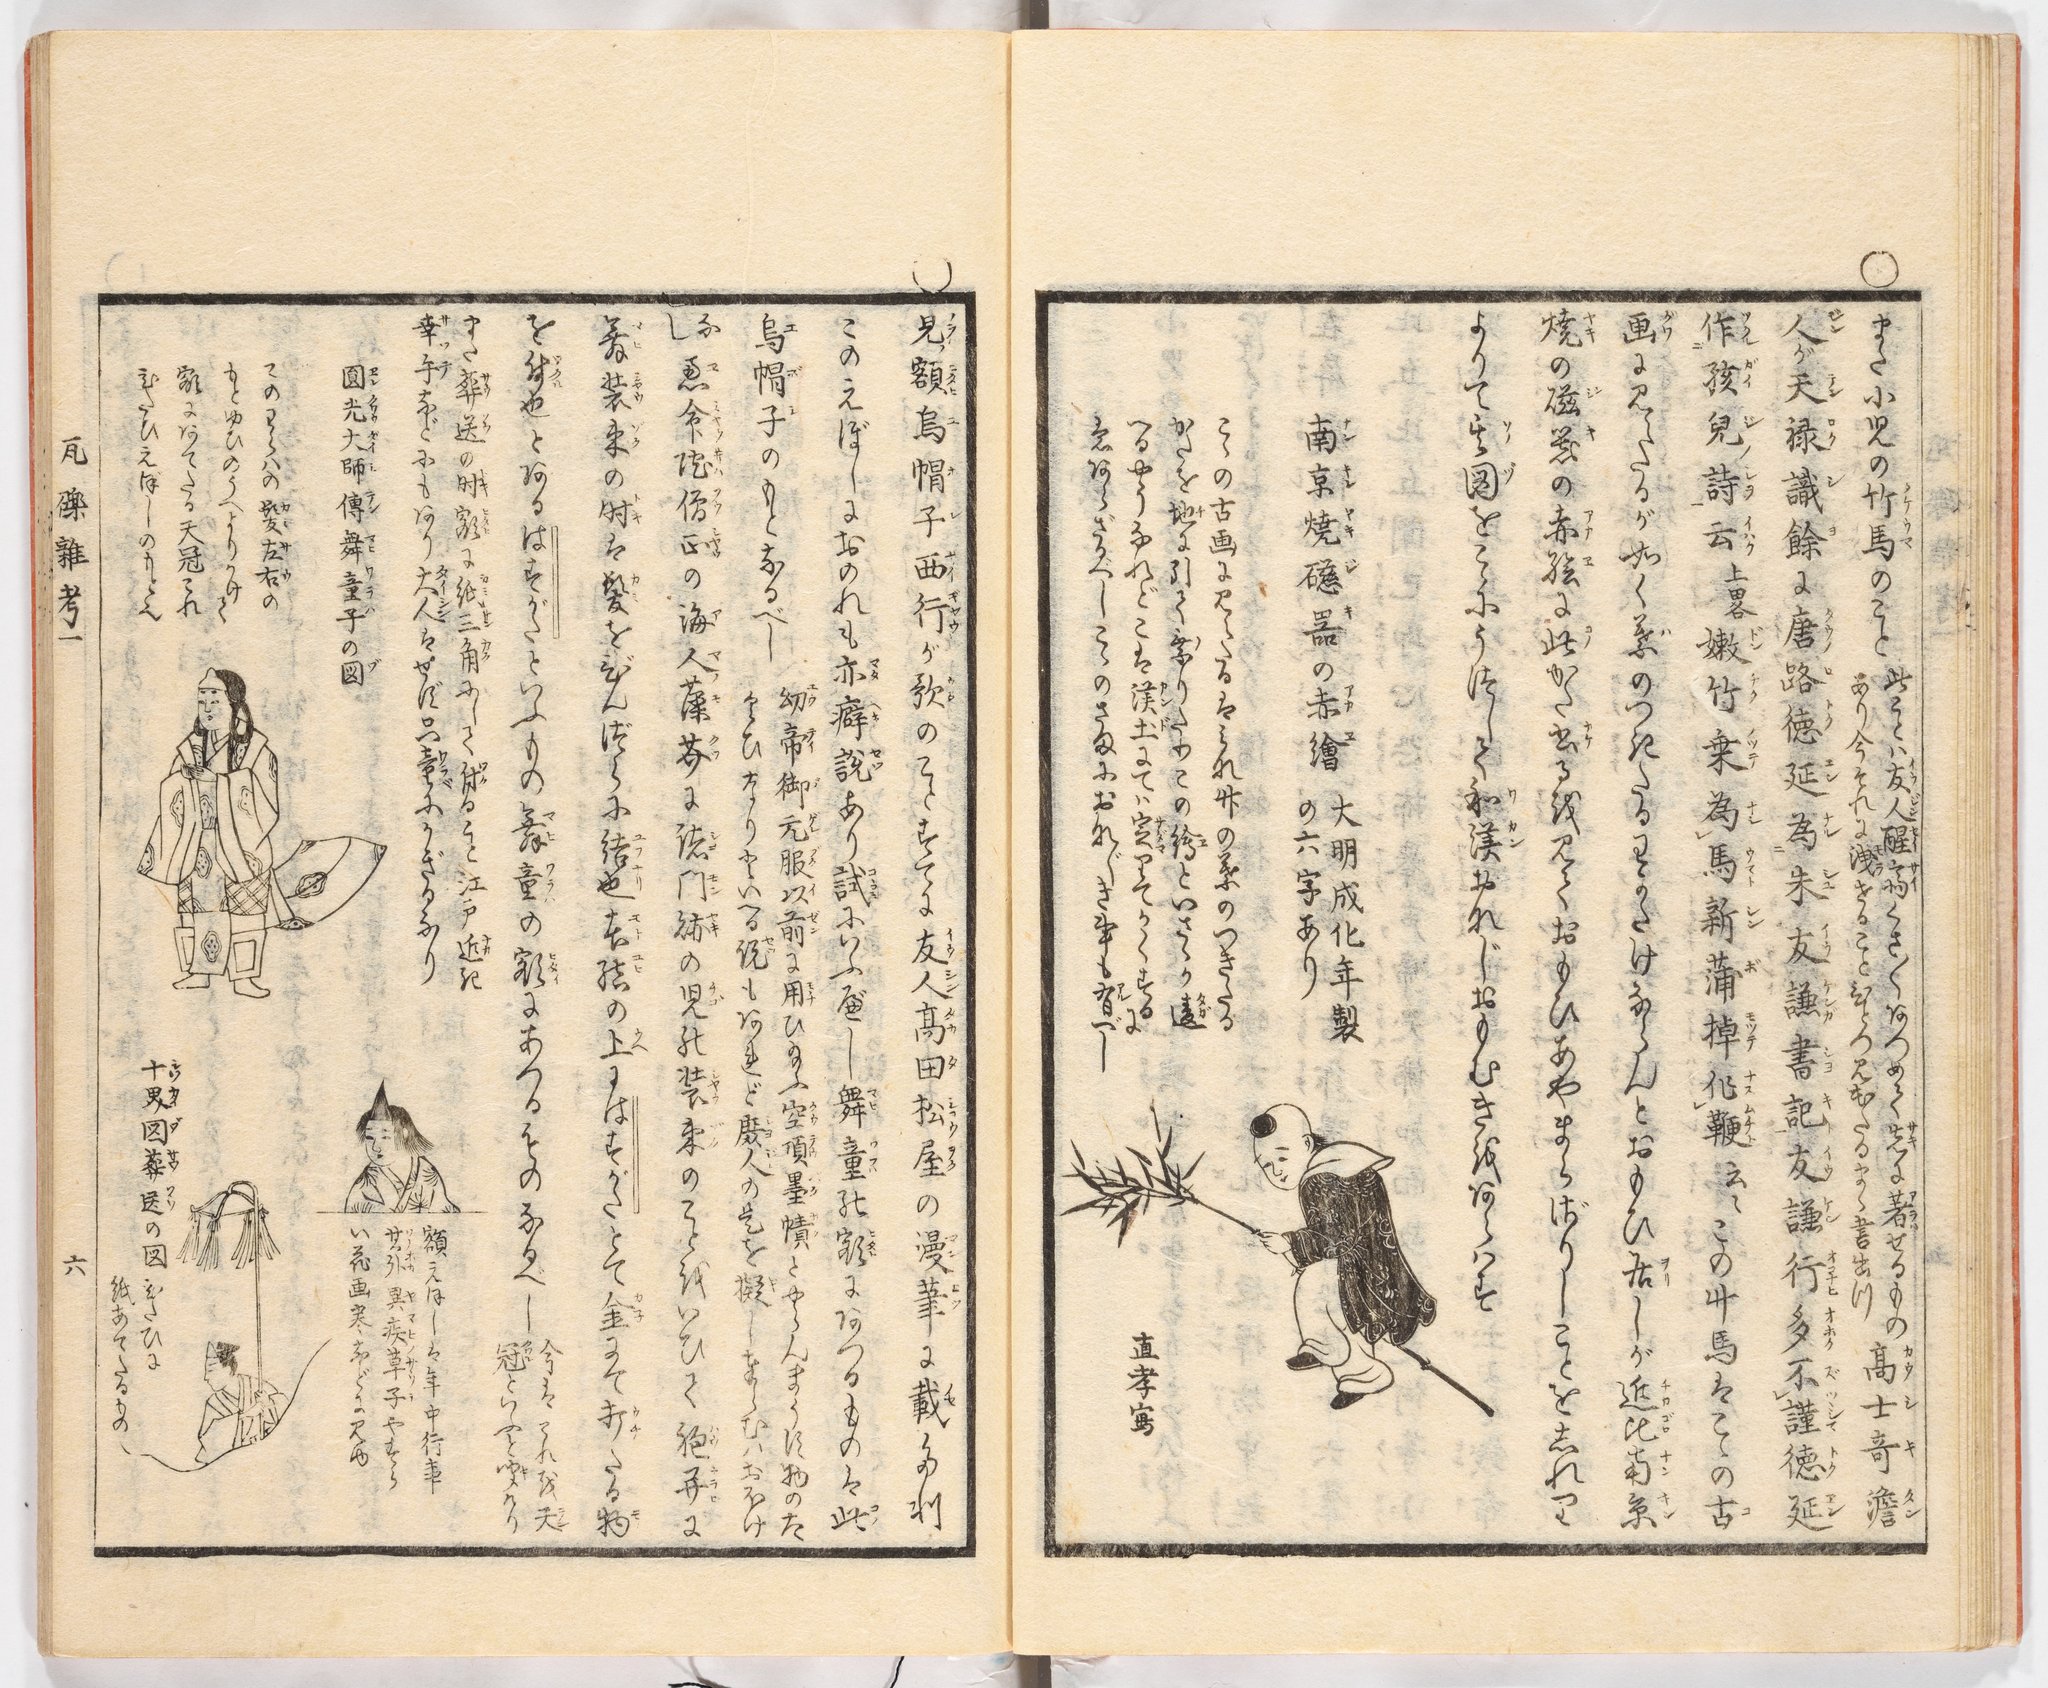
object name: illustrated book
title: Gareki zakko, Vol. 1 (notes on miscellaneous rubble)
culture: japanese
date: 1815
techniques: woodblock print